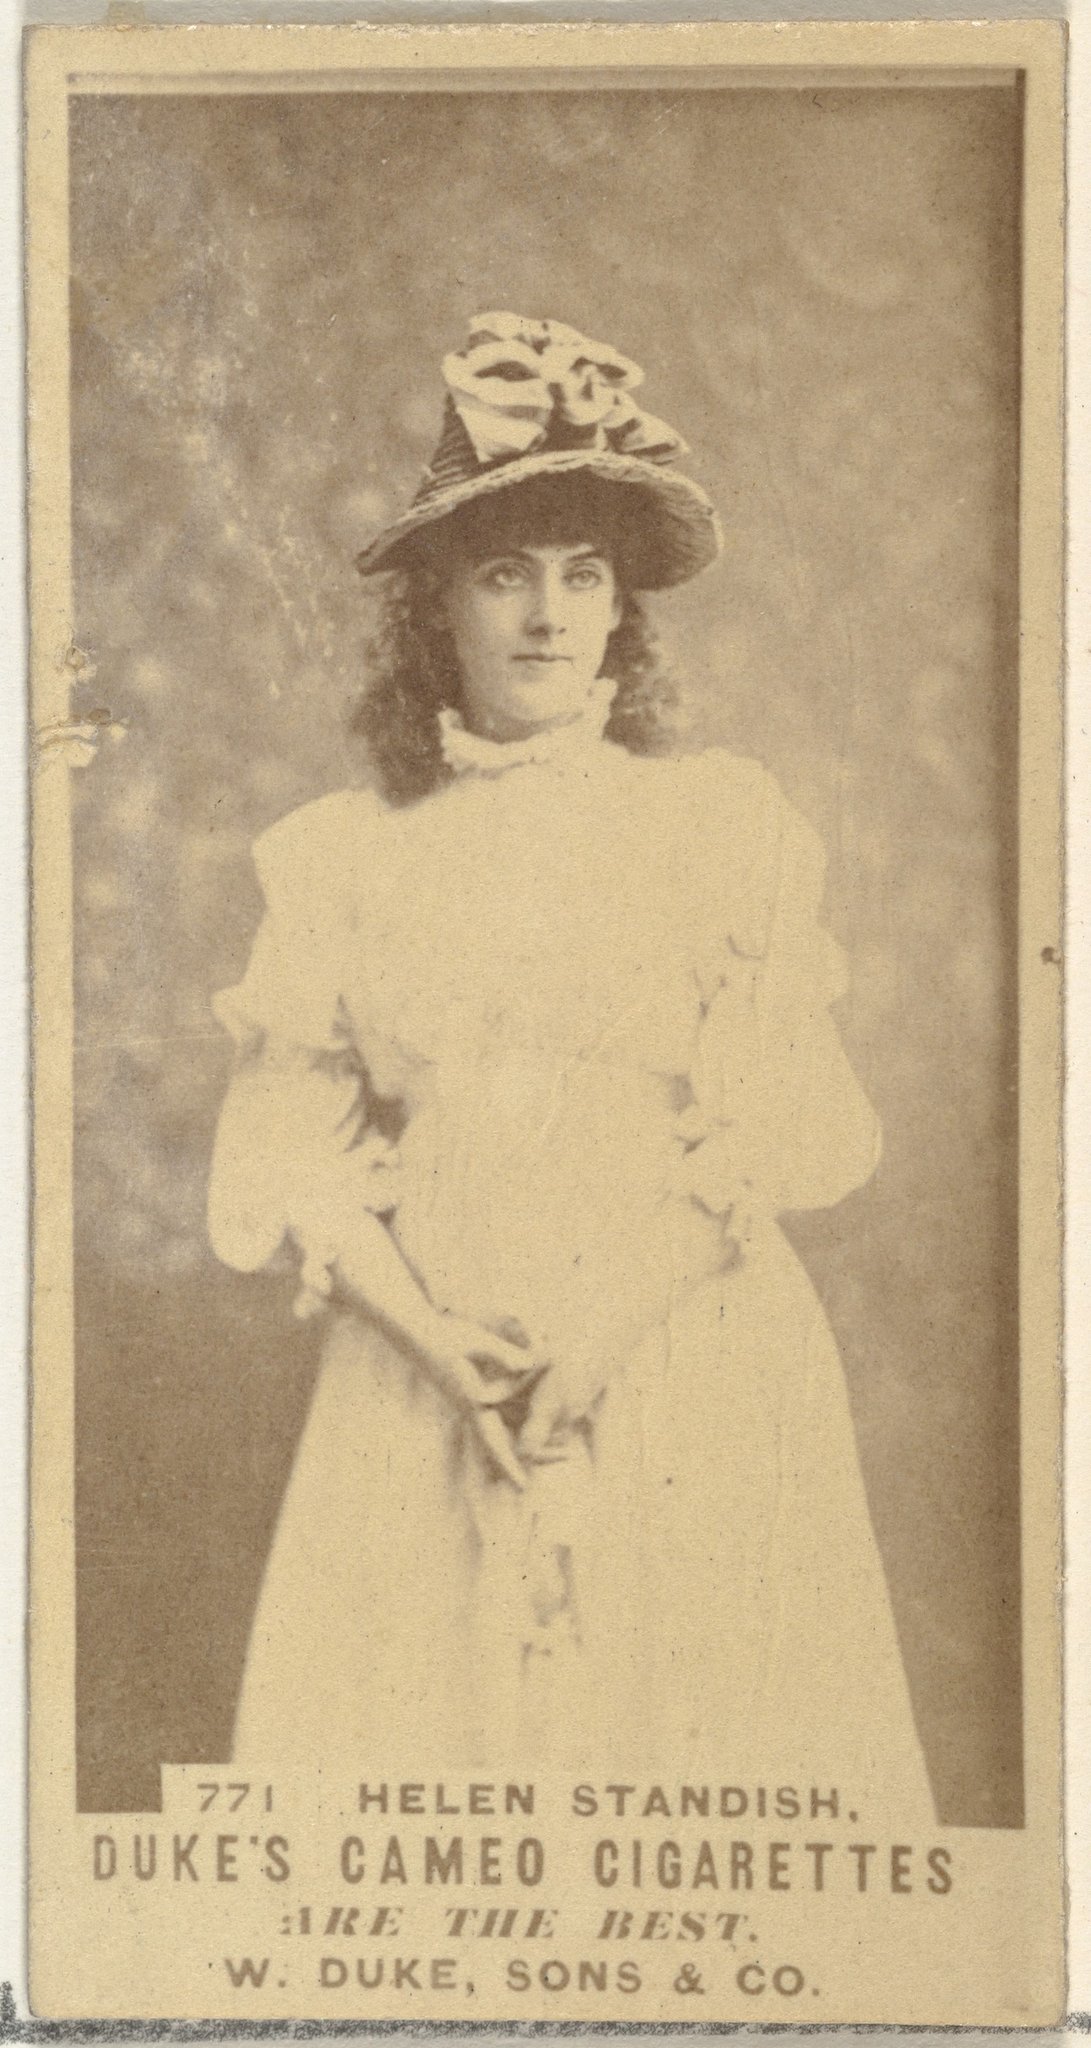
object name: photograph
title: Card Number 771, Helen Standish, from the Actors and Actresses series (N145-5) issued by Duke Sons & Co. to promote Cameo Cigarettes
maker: w. duke, sons & co.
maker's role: publisher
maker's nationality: american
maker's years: 1870-1920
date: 1880-1889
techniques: albumen silver print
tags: portraits,women,actresses